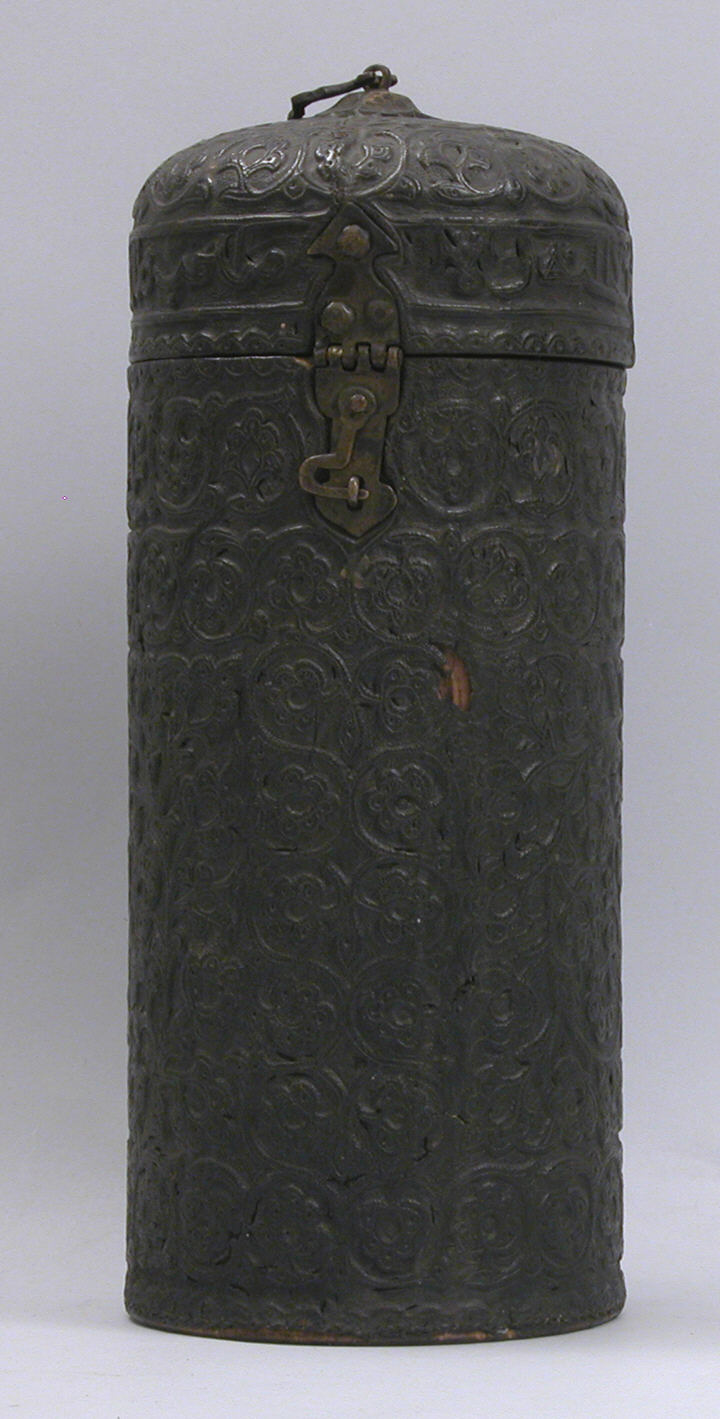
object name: case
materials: leather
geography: egypt or syria